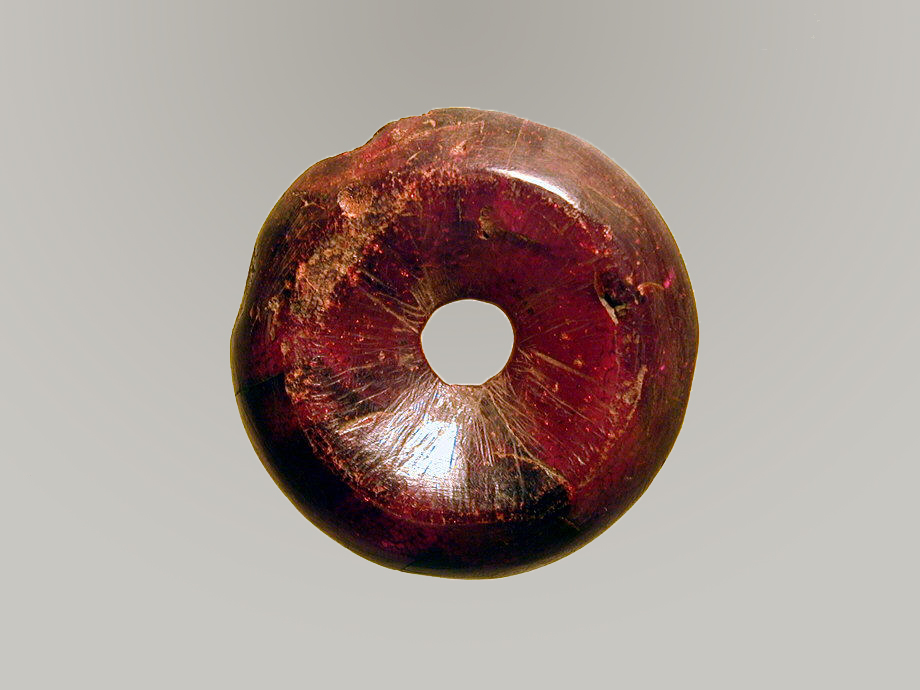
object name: whorl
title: Pierced disk, perhaps from an earring or fibula (safety pin)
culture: etruscan or italic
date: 700-601 BCE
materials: amber